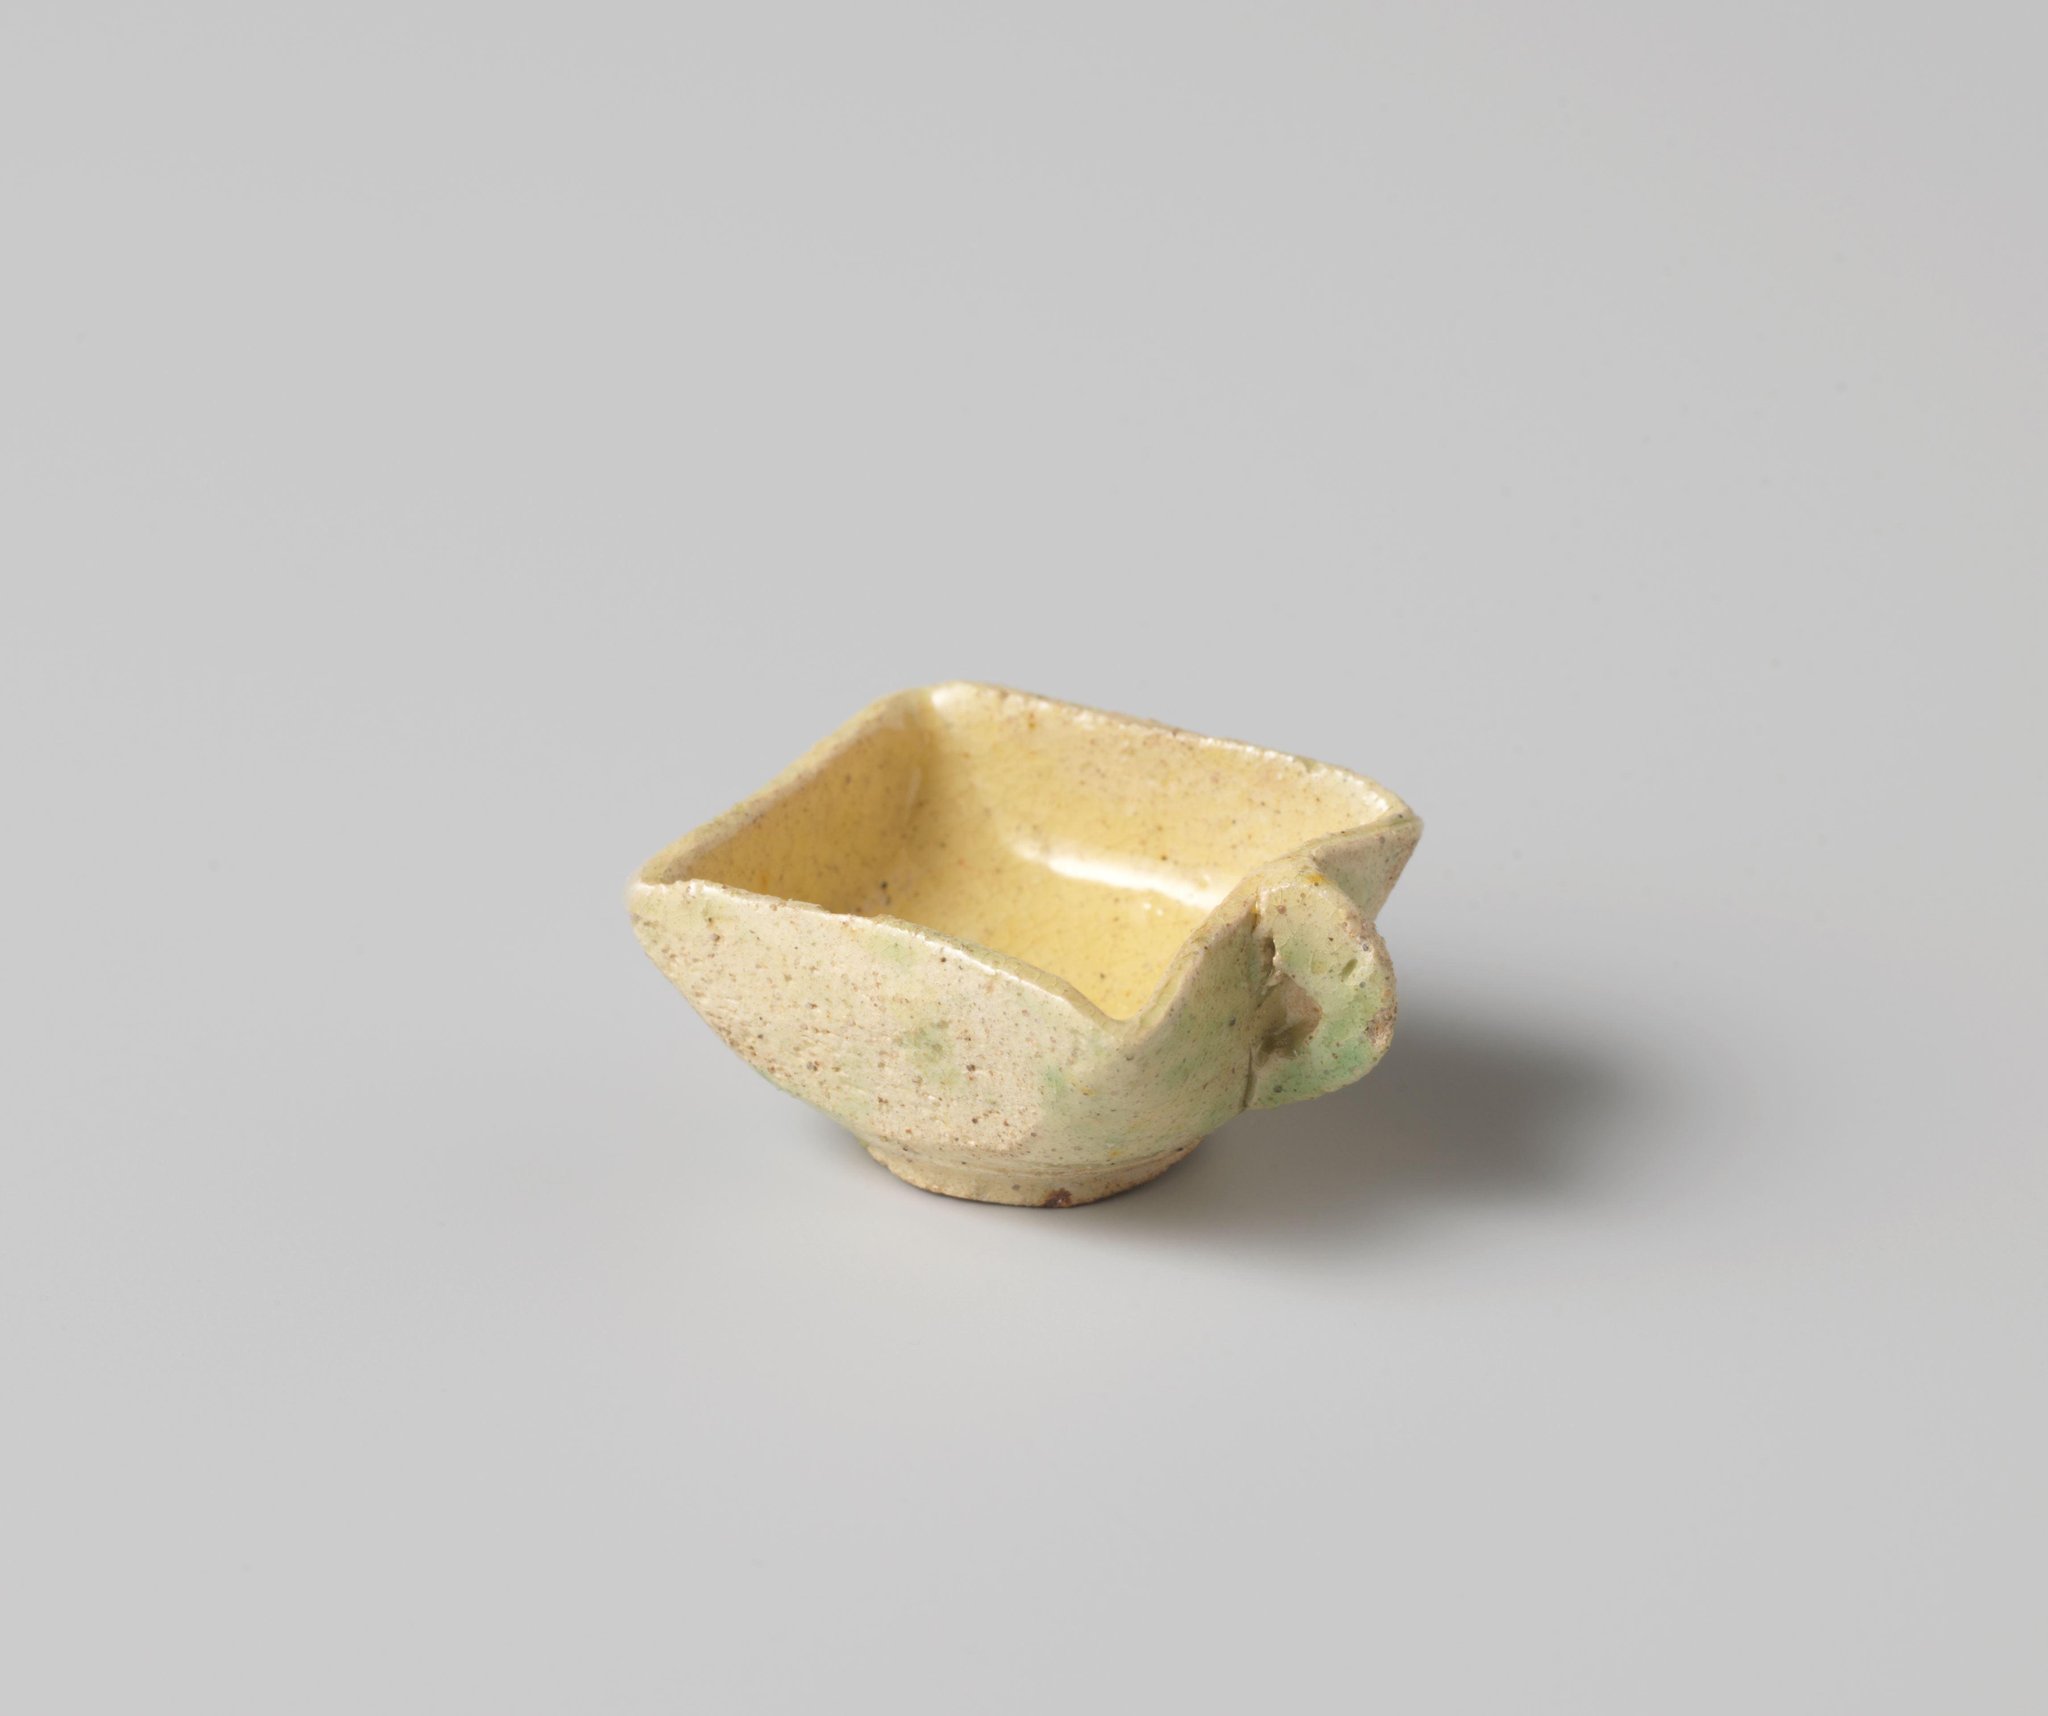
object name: miniature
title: Vuurtest met groengevlekte glazuur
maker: Anonymous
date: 1700-1799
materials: earthenware, glaze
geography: netherlands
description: Vuurtest van aardewerk, witbakkende klei met op buitenzijde groengevlekte loodglazuur.